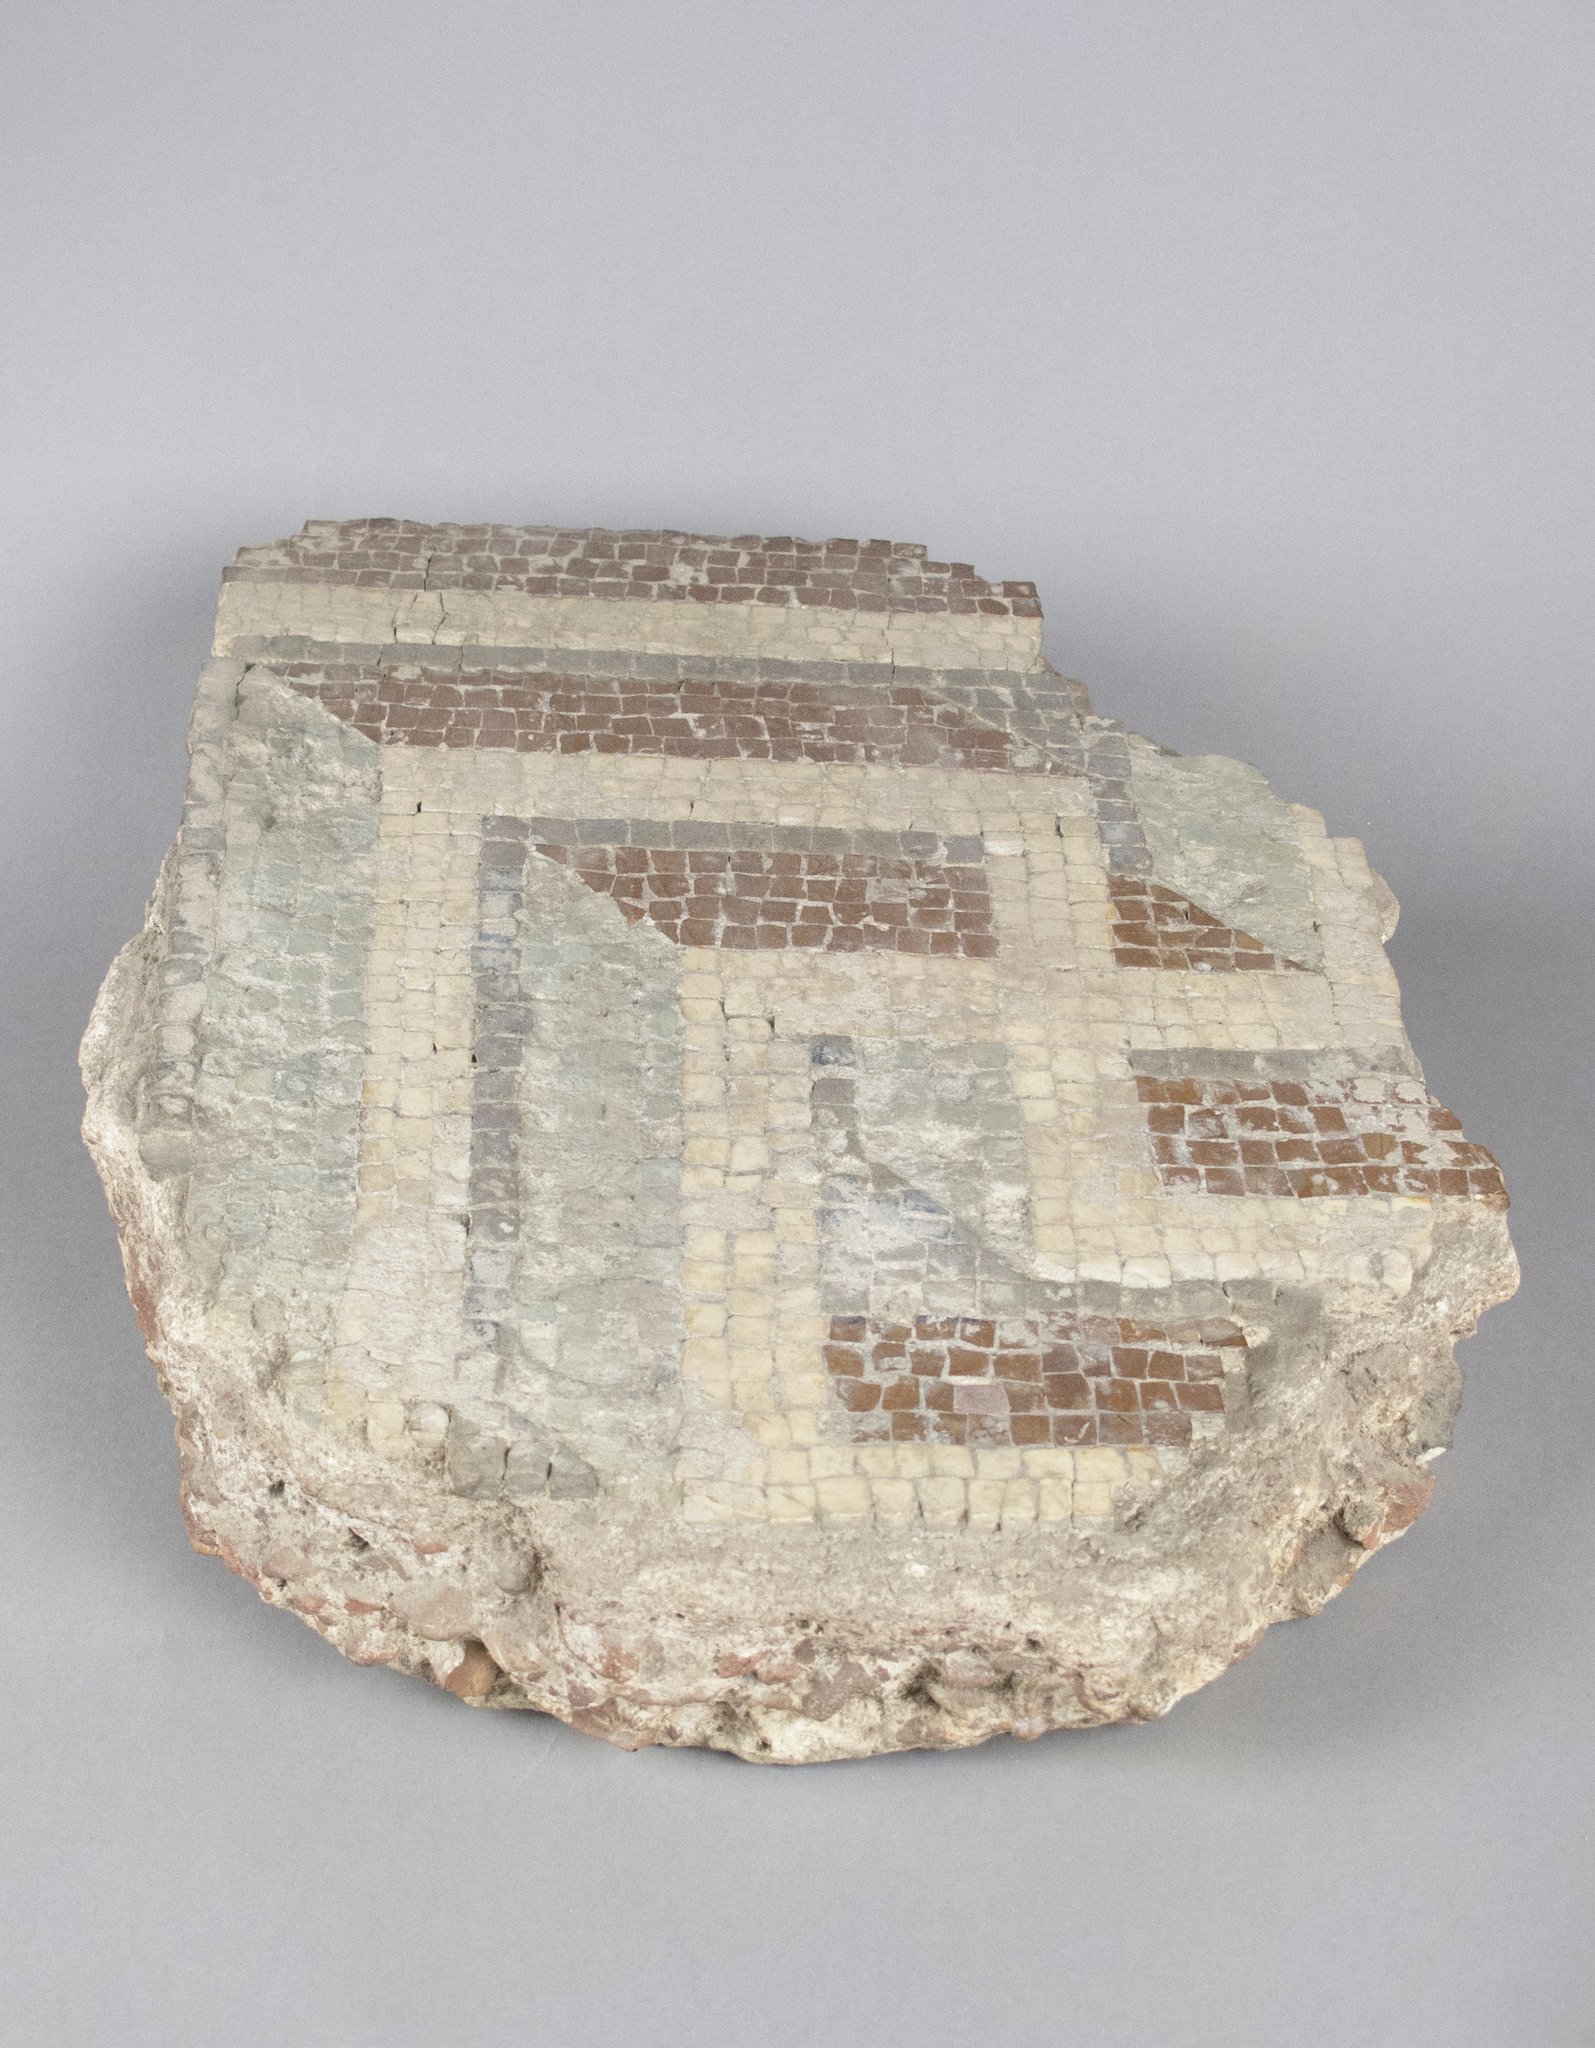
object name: mosaic floor fragment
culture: roman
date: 670 BCE-330 CE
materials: mortar